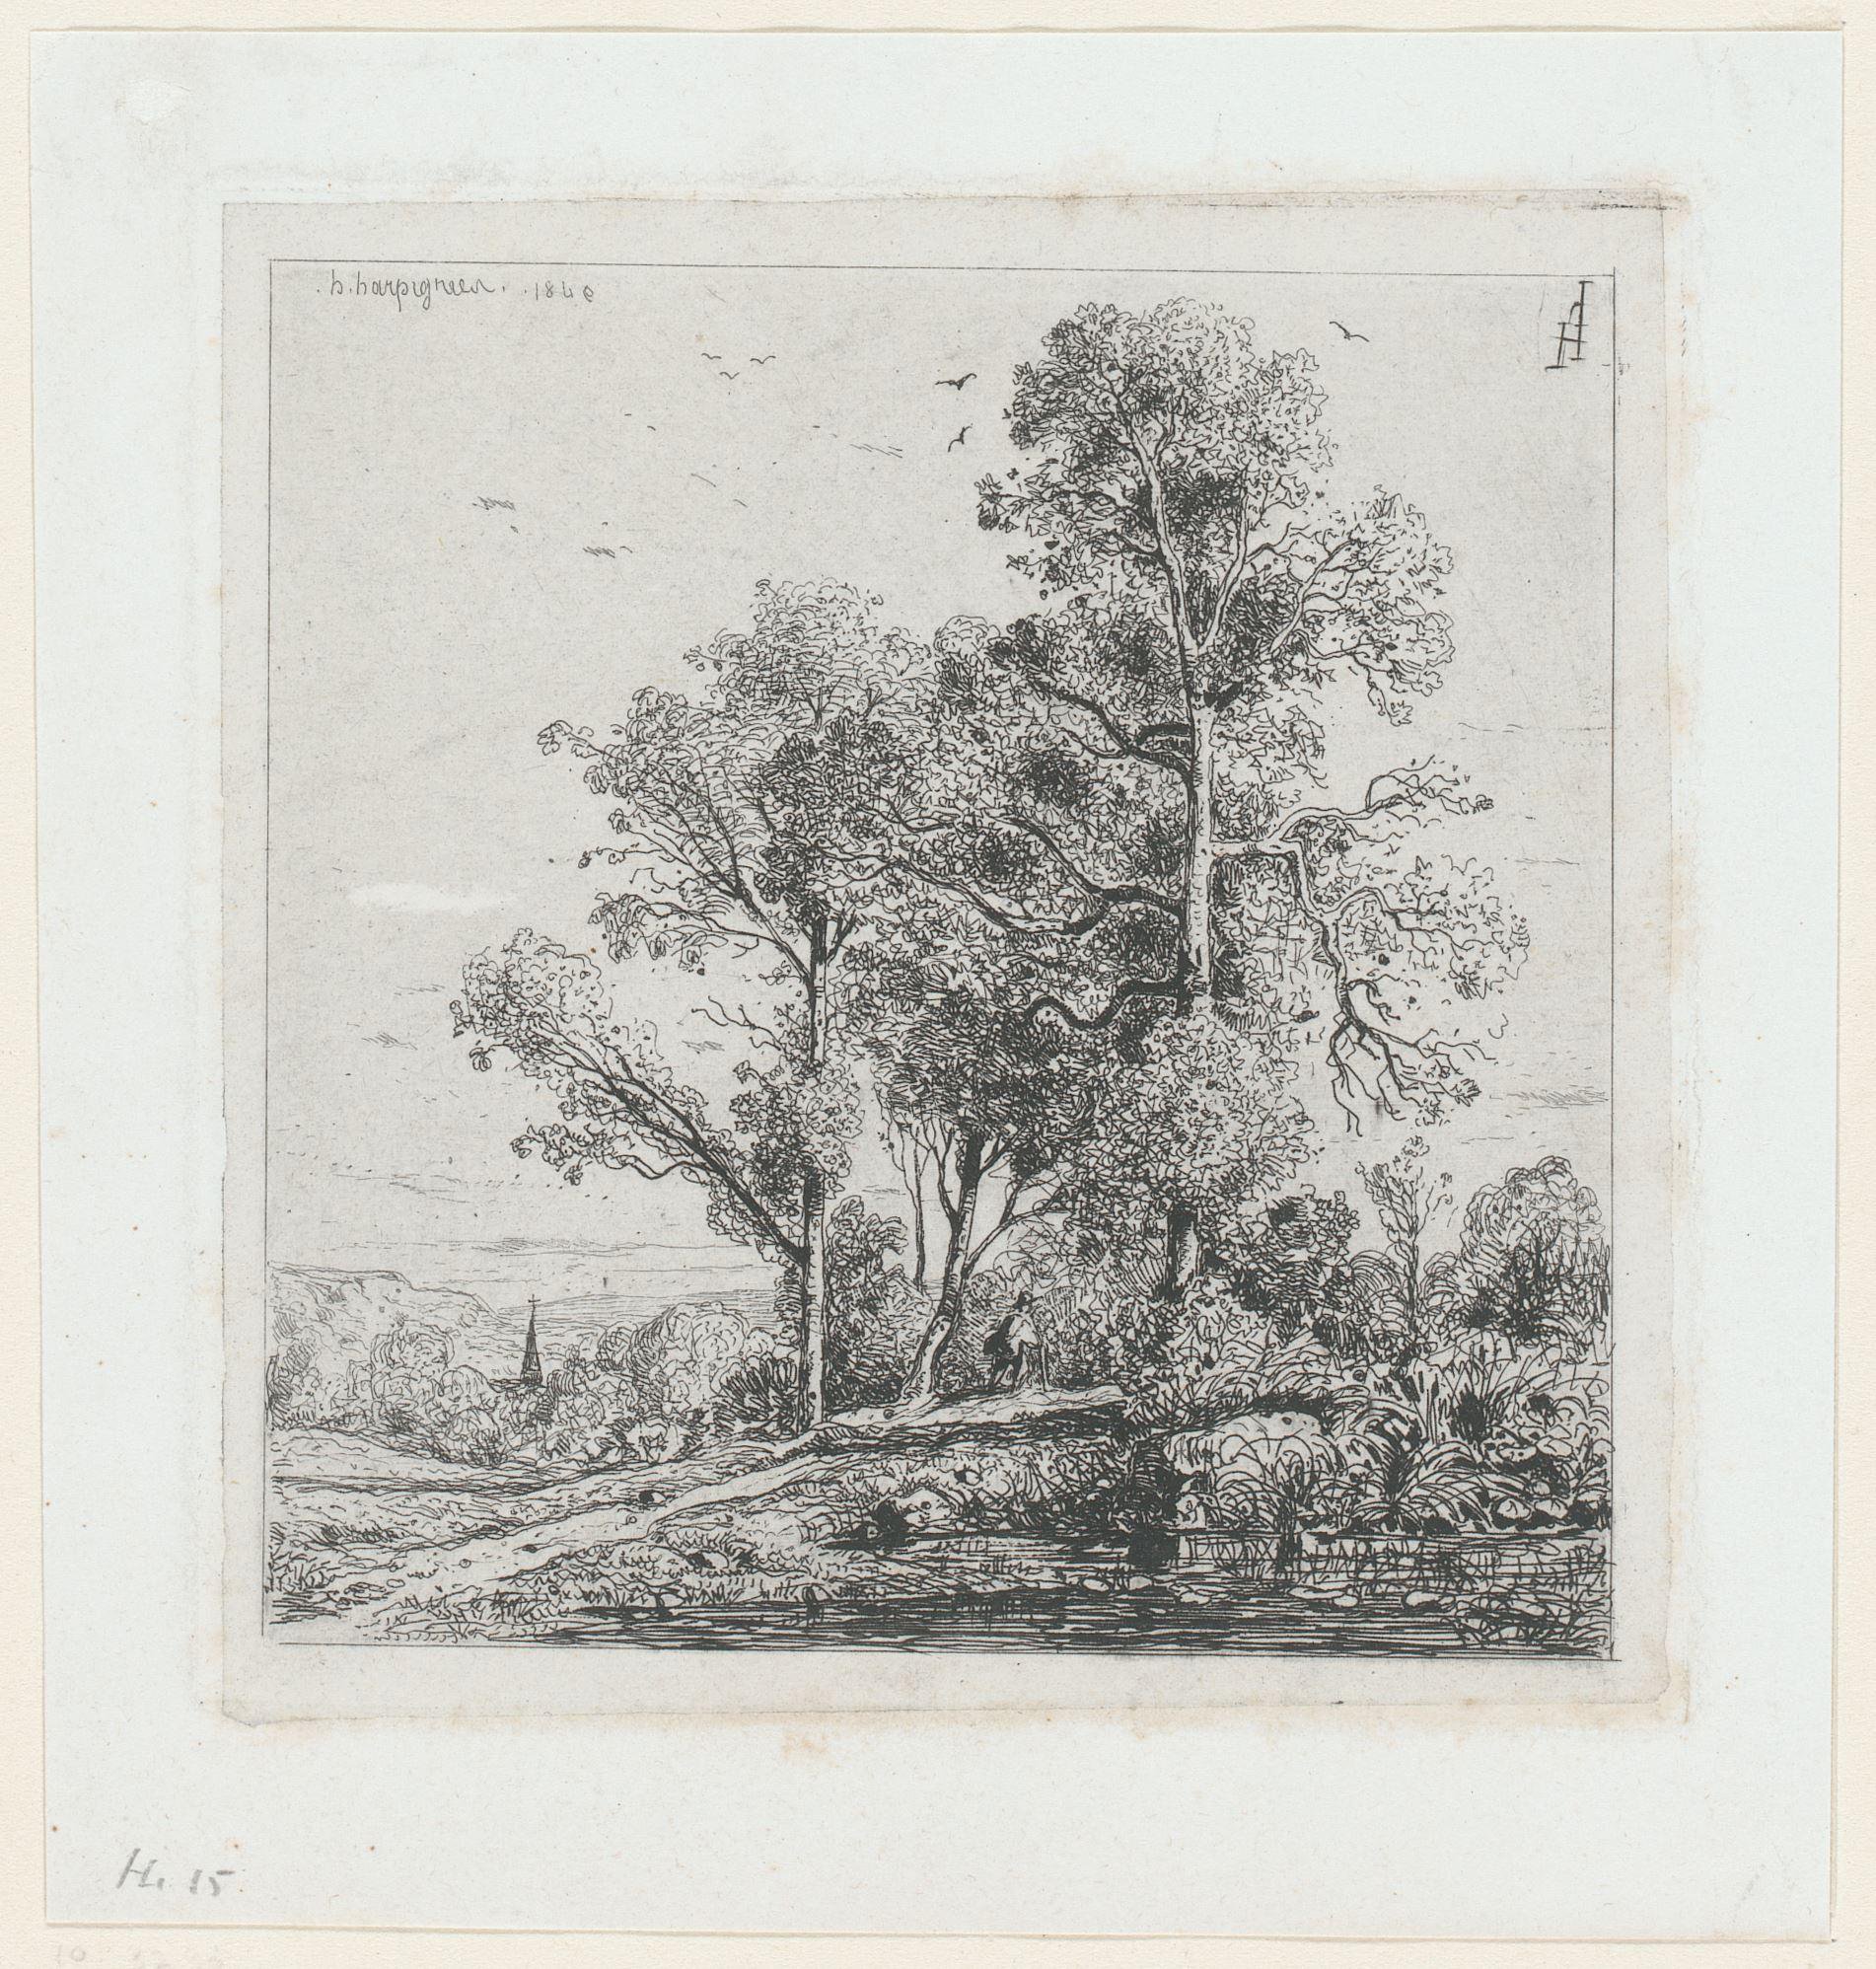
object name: print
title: Landschap met een figuur op een pad langs een vijver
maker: henri joseph harpignies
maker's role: draughtsman, print maker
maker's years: 1819-1916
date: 1840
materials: paper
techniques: etching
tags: landscapes, road, path, pond, pool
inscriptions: collector's mark: Lugt 2228, collector's mark: Lugt 1485